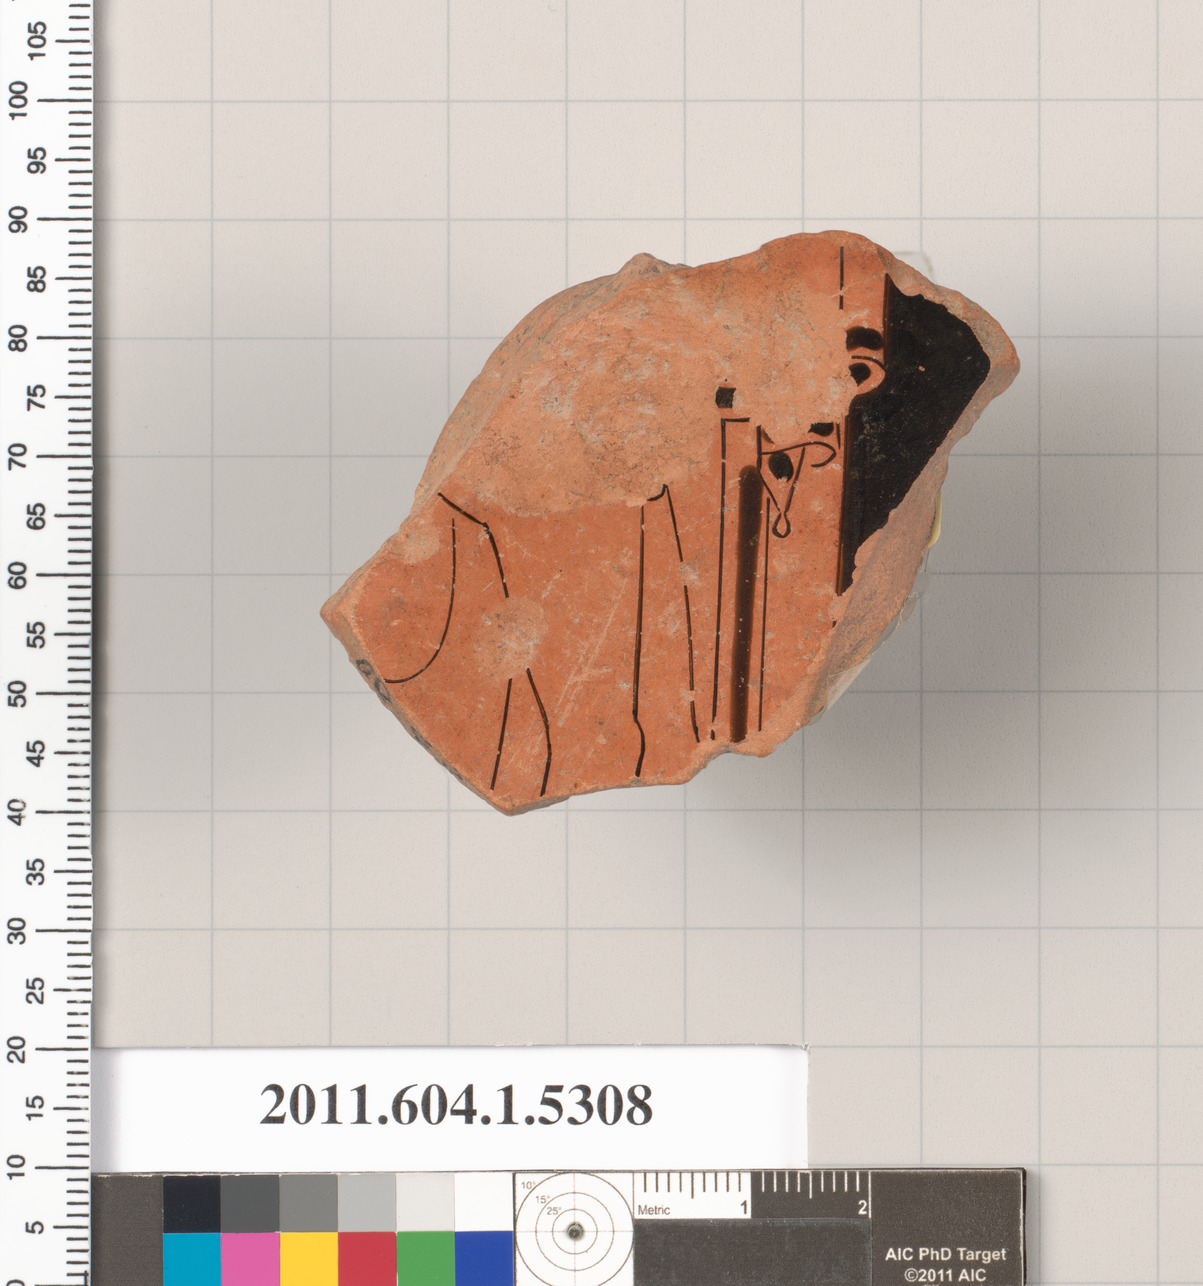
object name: kylix fragment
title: Terracotta fragment of a kylix (drinking cup)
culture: greek, attic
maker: telephos painter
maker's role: artist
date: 480-470 BCE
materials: terracotta